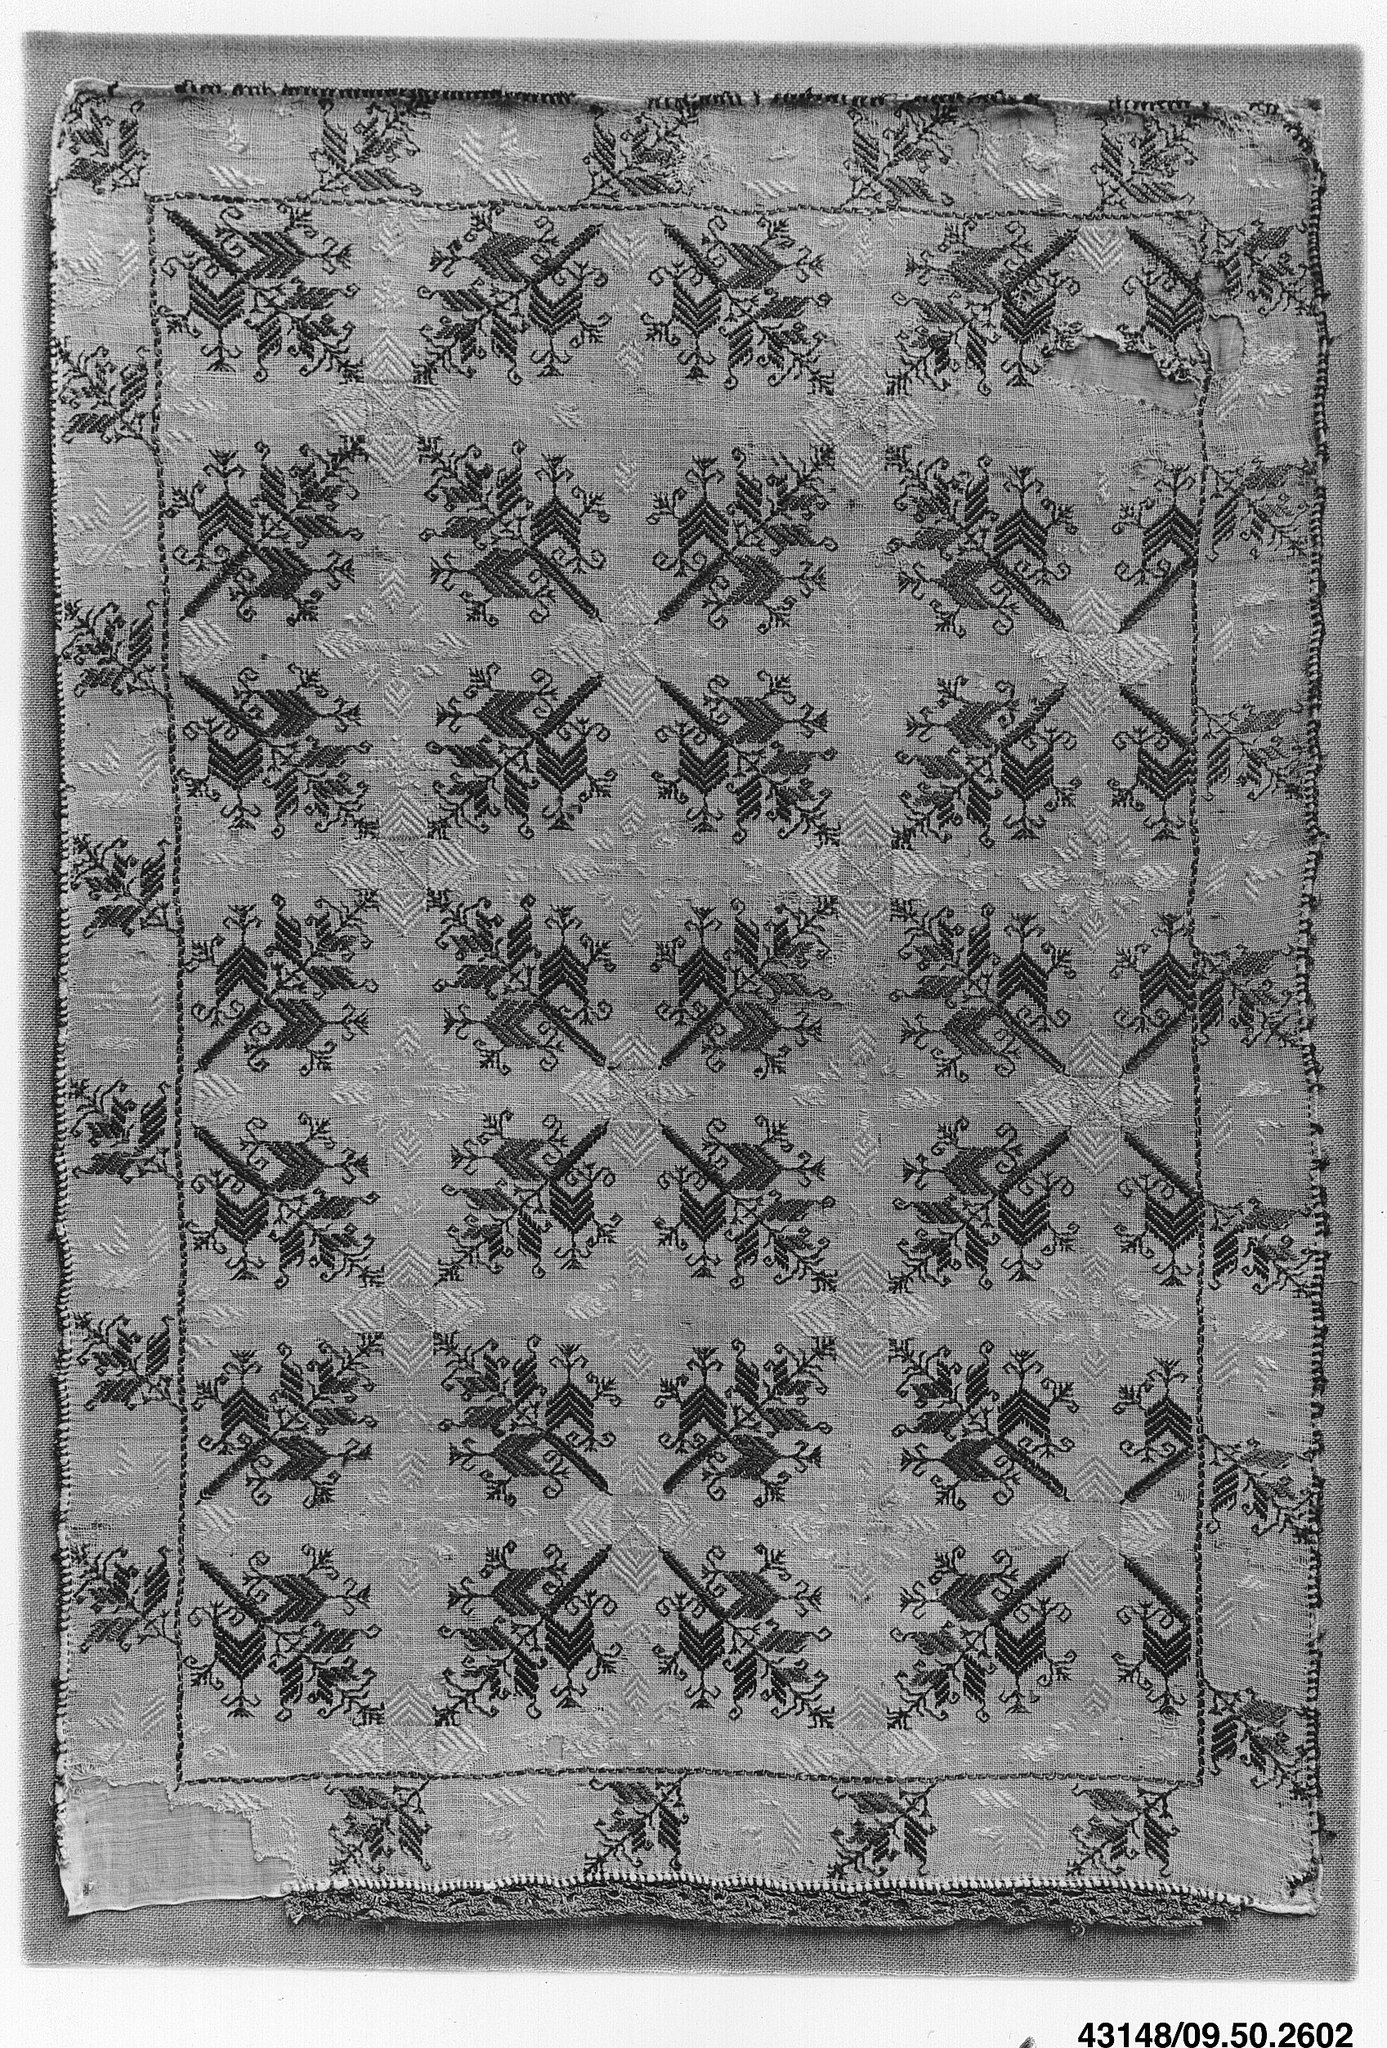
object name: panel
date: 1601-1700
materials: linen, silk